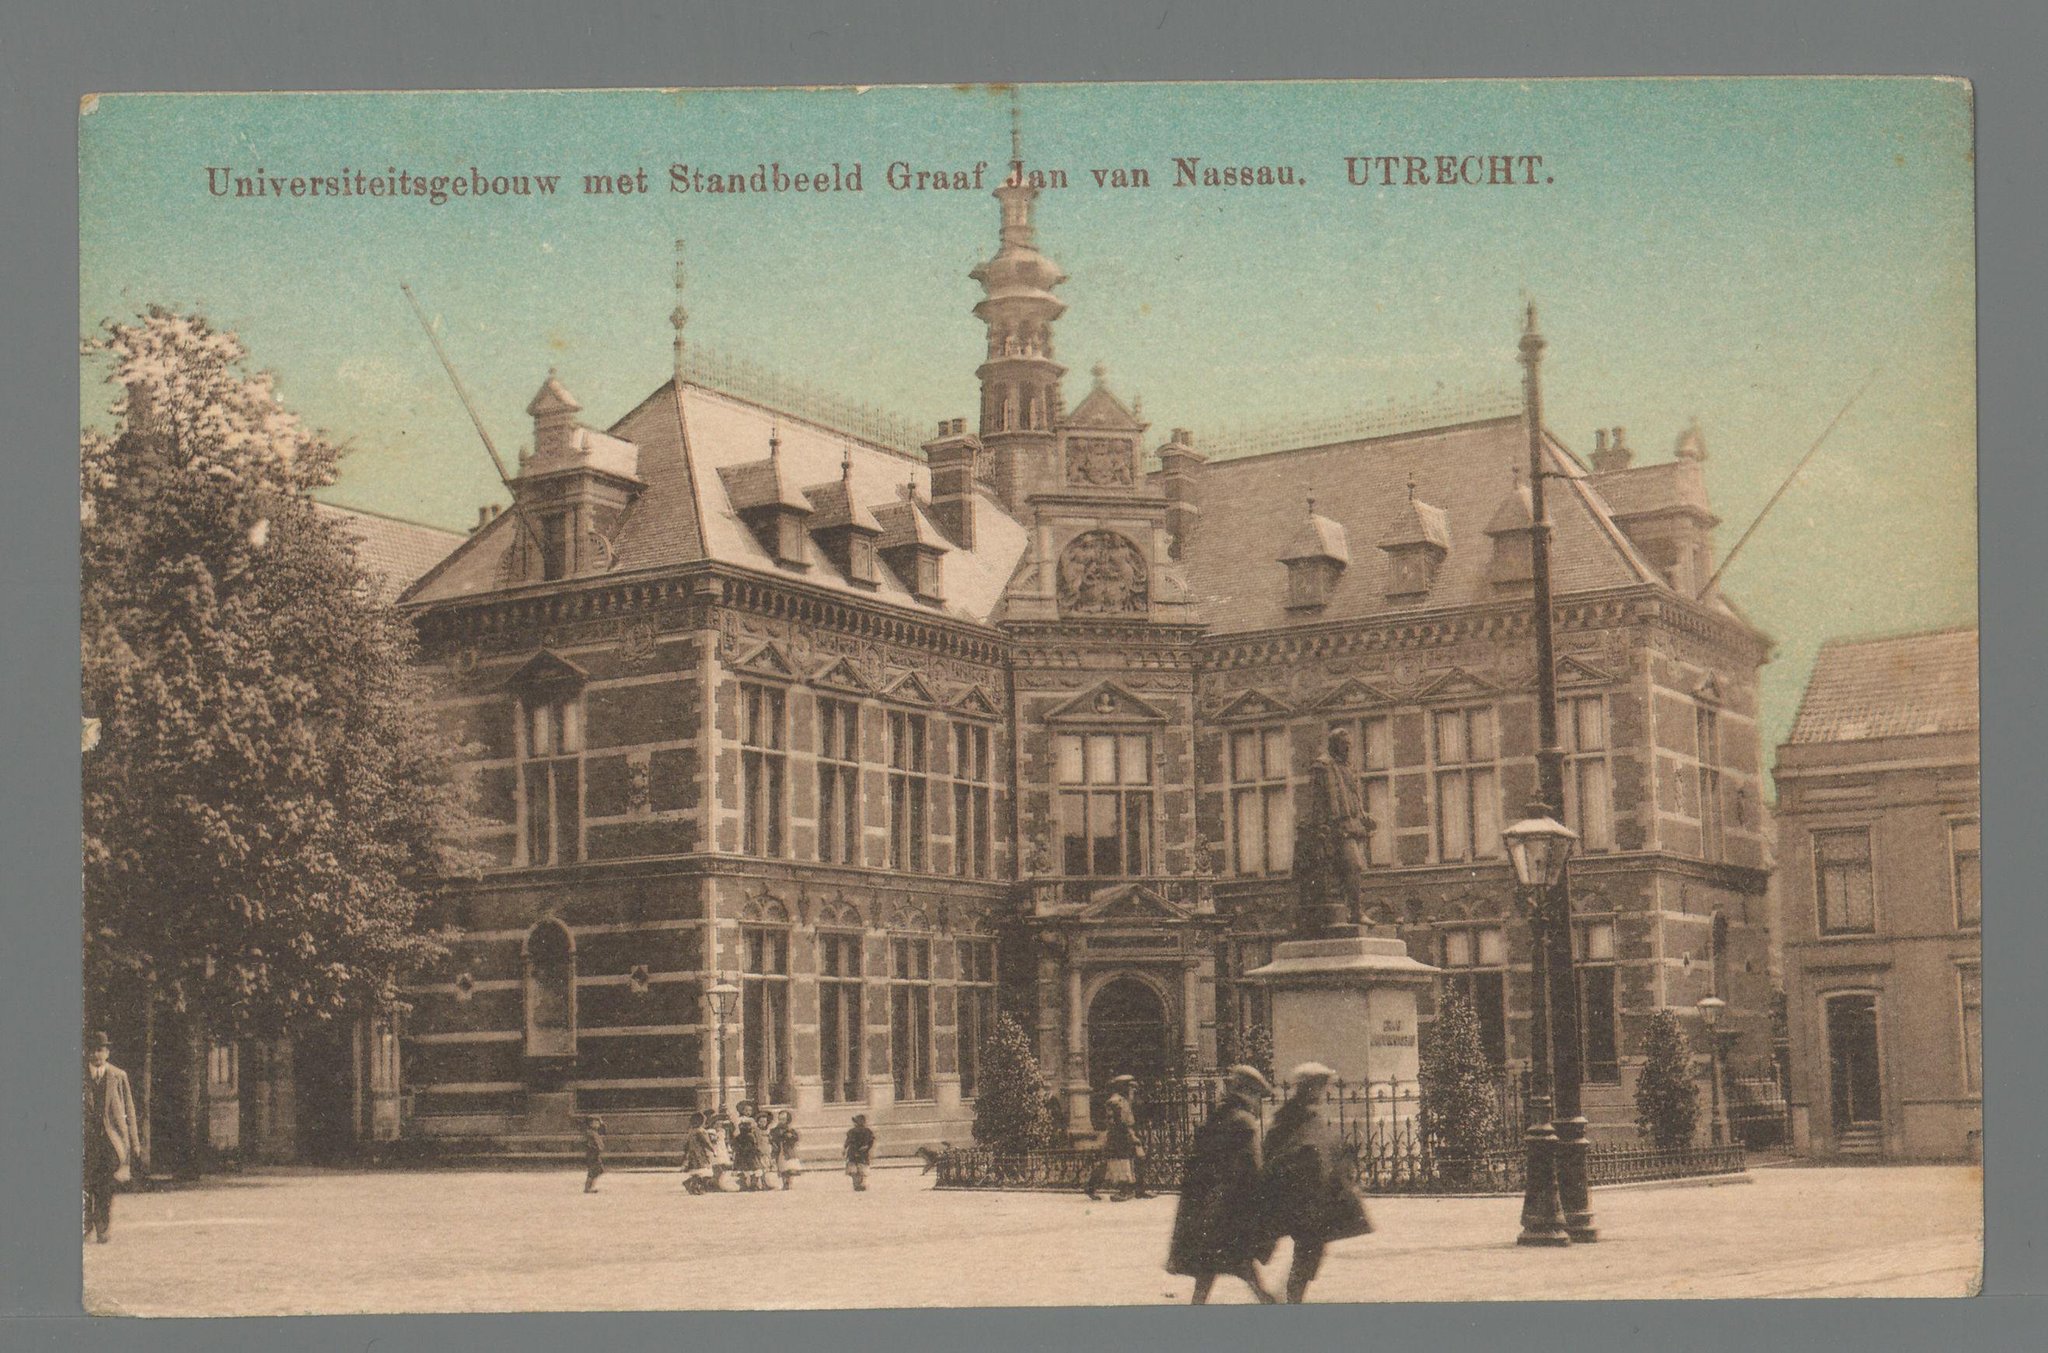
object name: photomechanical print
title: Universiteitsgebouw met standbeeld Graaf Jan van Nassau. Utrecht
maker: Anonymous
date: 1905-1912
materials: cardboard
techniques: photograph, lithograph, writing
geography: haarlem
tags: monument, statue, university building, college, utrecht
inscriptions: postage stamp